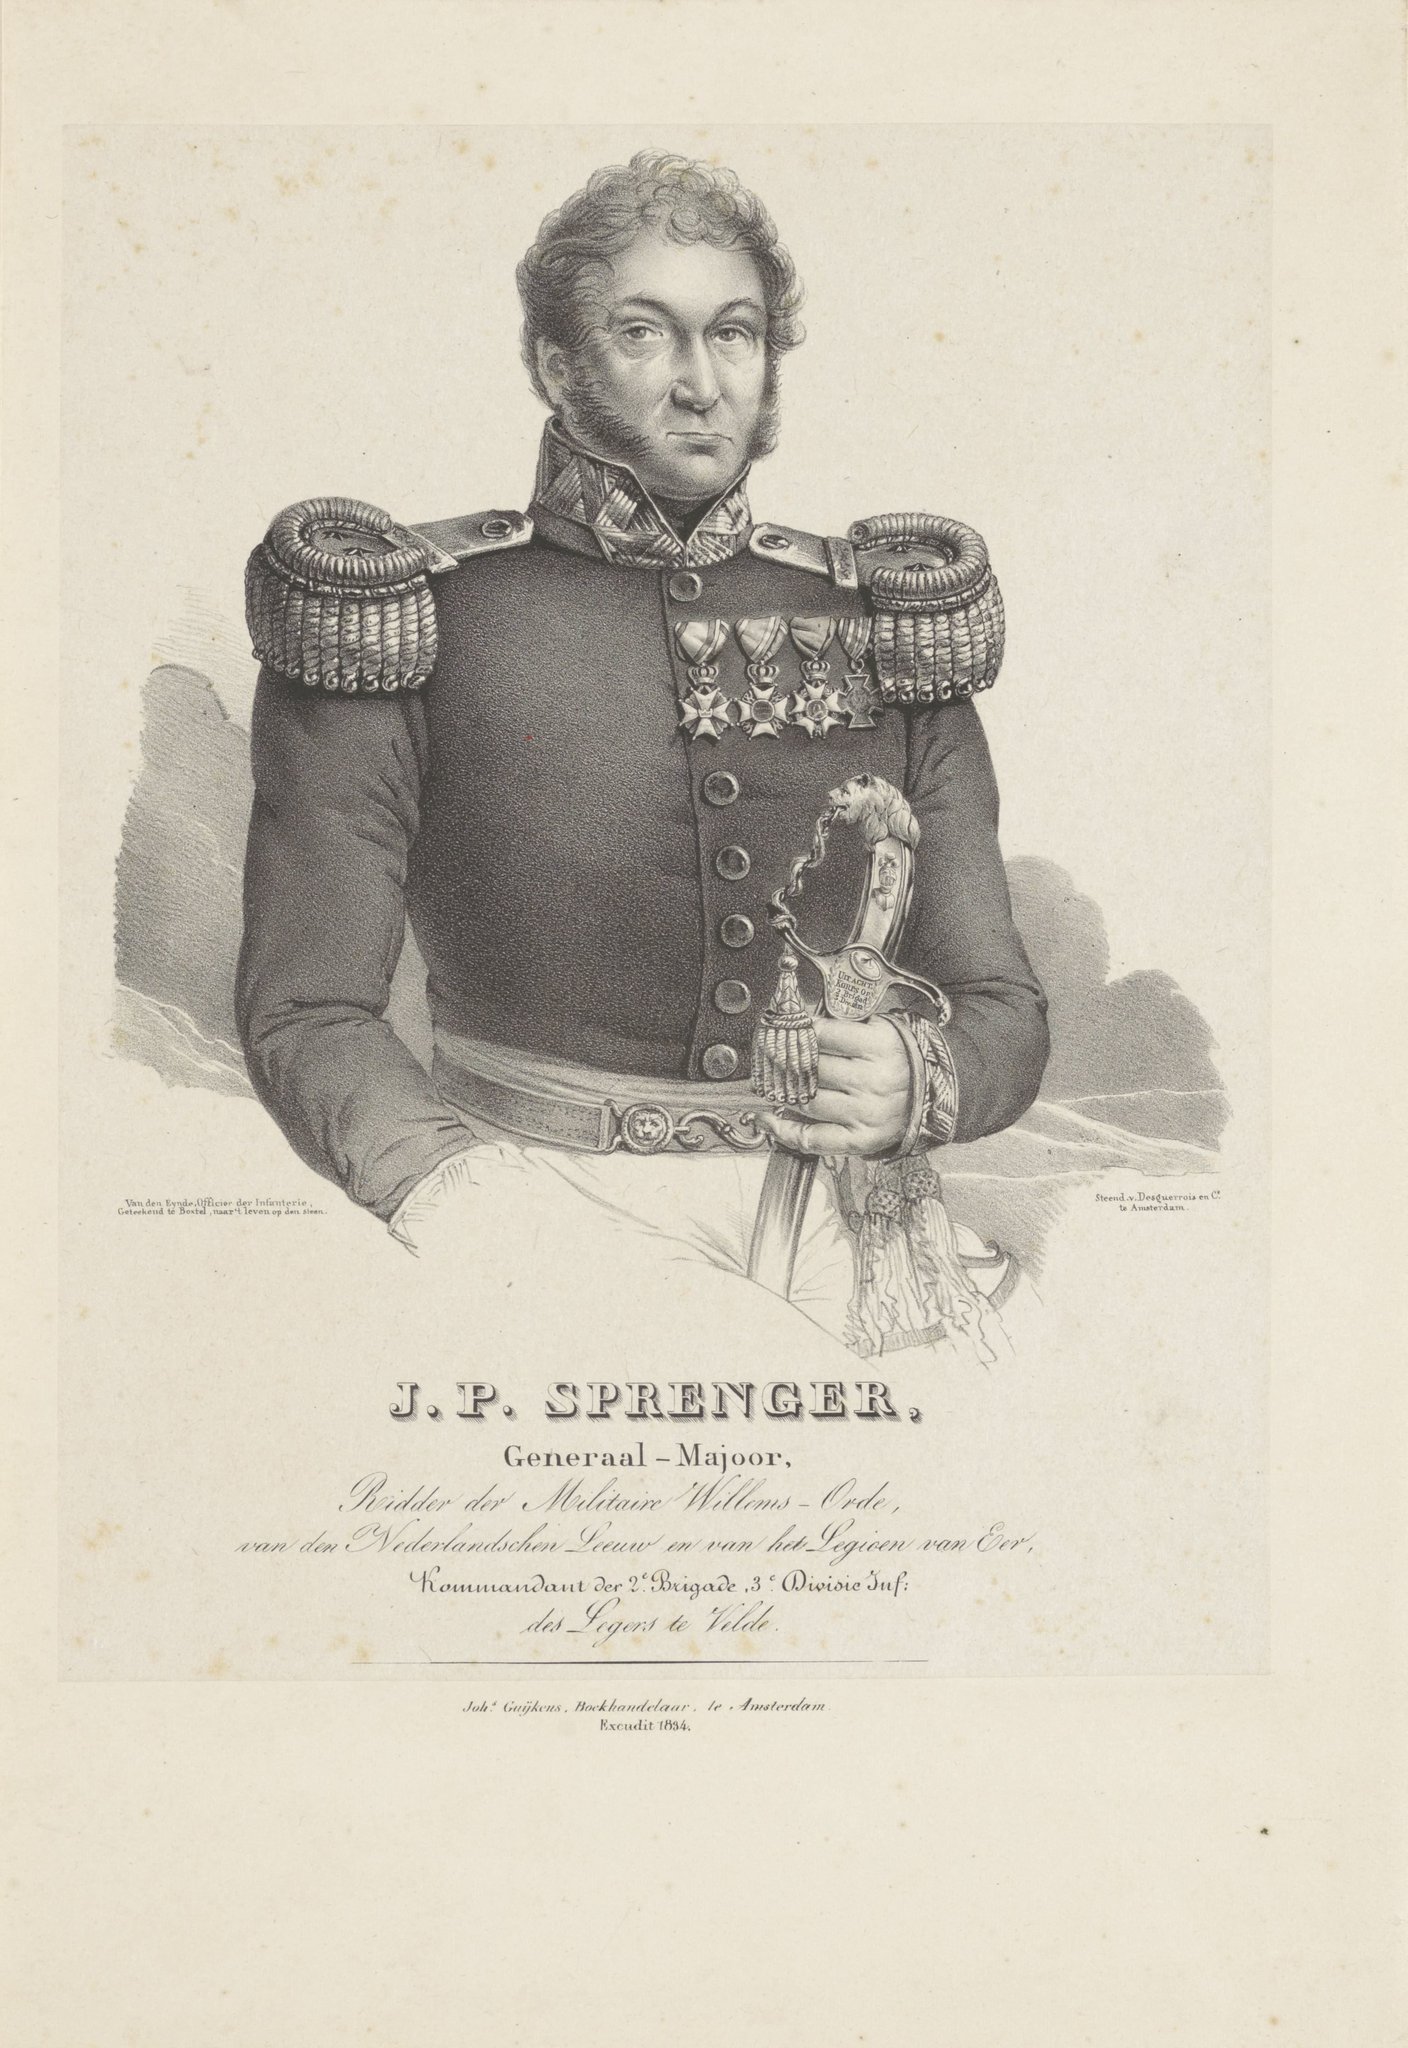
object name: print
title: Portret van Johannes Petrus Sprenger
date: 1834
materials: paper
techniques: lithograph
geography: amsterdam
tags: dordrecht, knighthood order, hacking and thrusting weapons (with name), historical persons (+ half-length portrait)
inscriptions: collector's mark: Lugt 2228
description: De geportretteerde draagt een militair uniform met epauletten met twee sterren, vier ridderorden op zijn borst en een eresabel in zijn linkerhand. Onder het portret zijn naam, titels en functies.